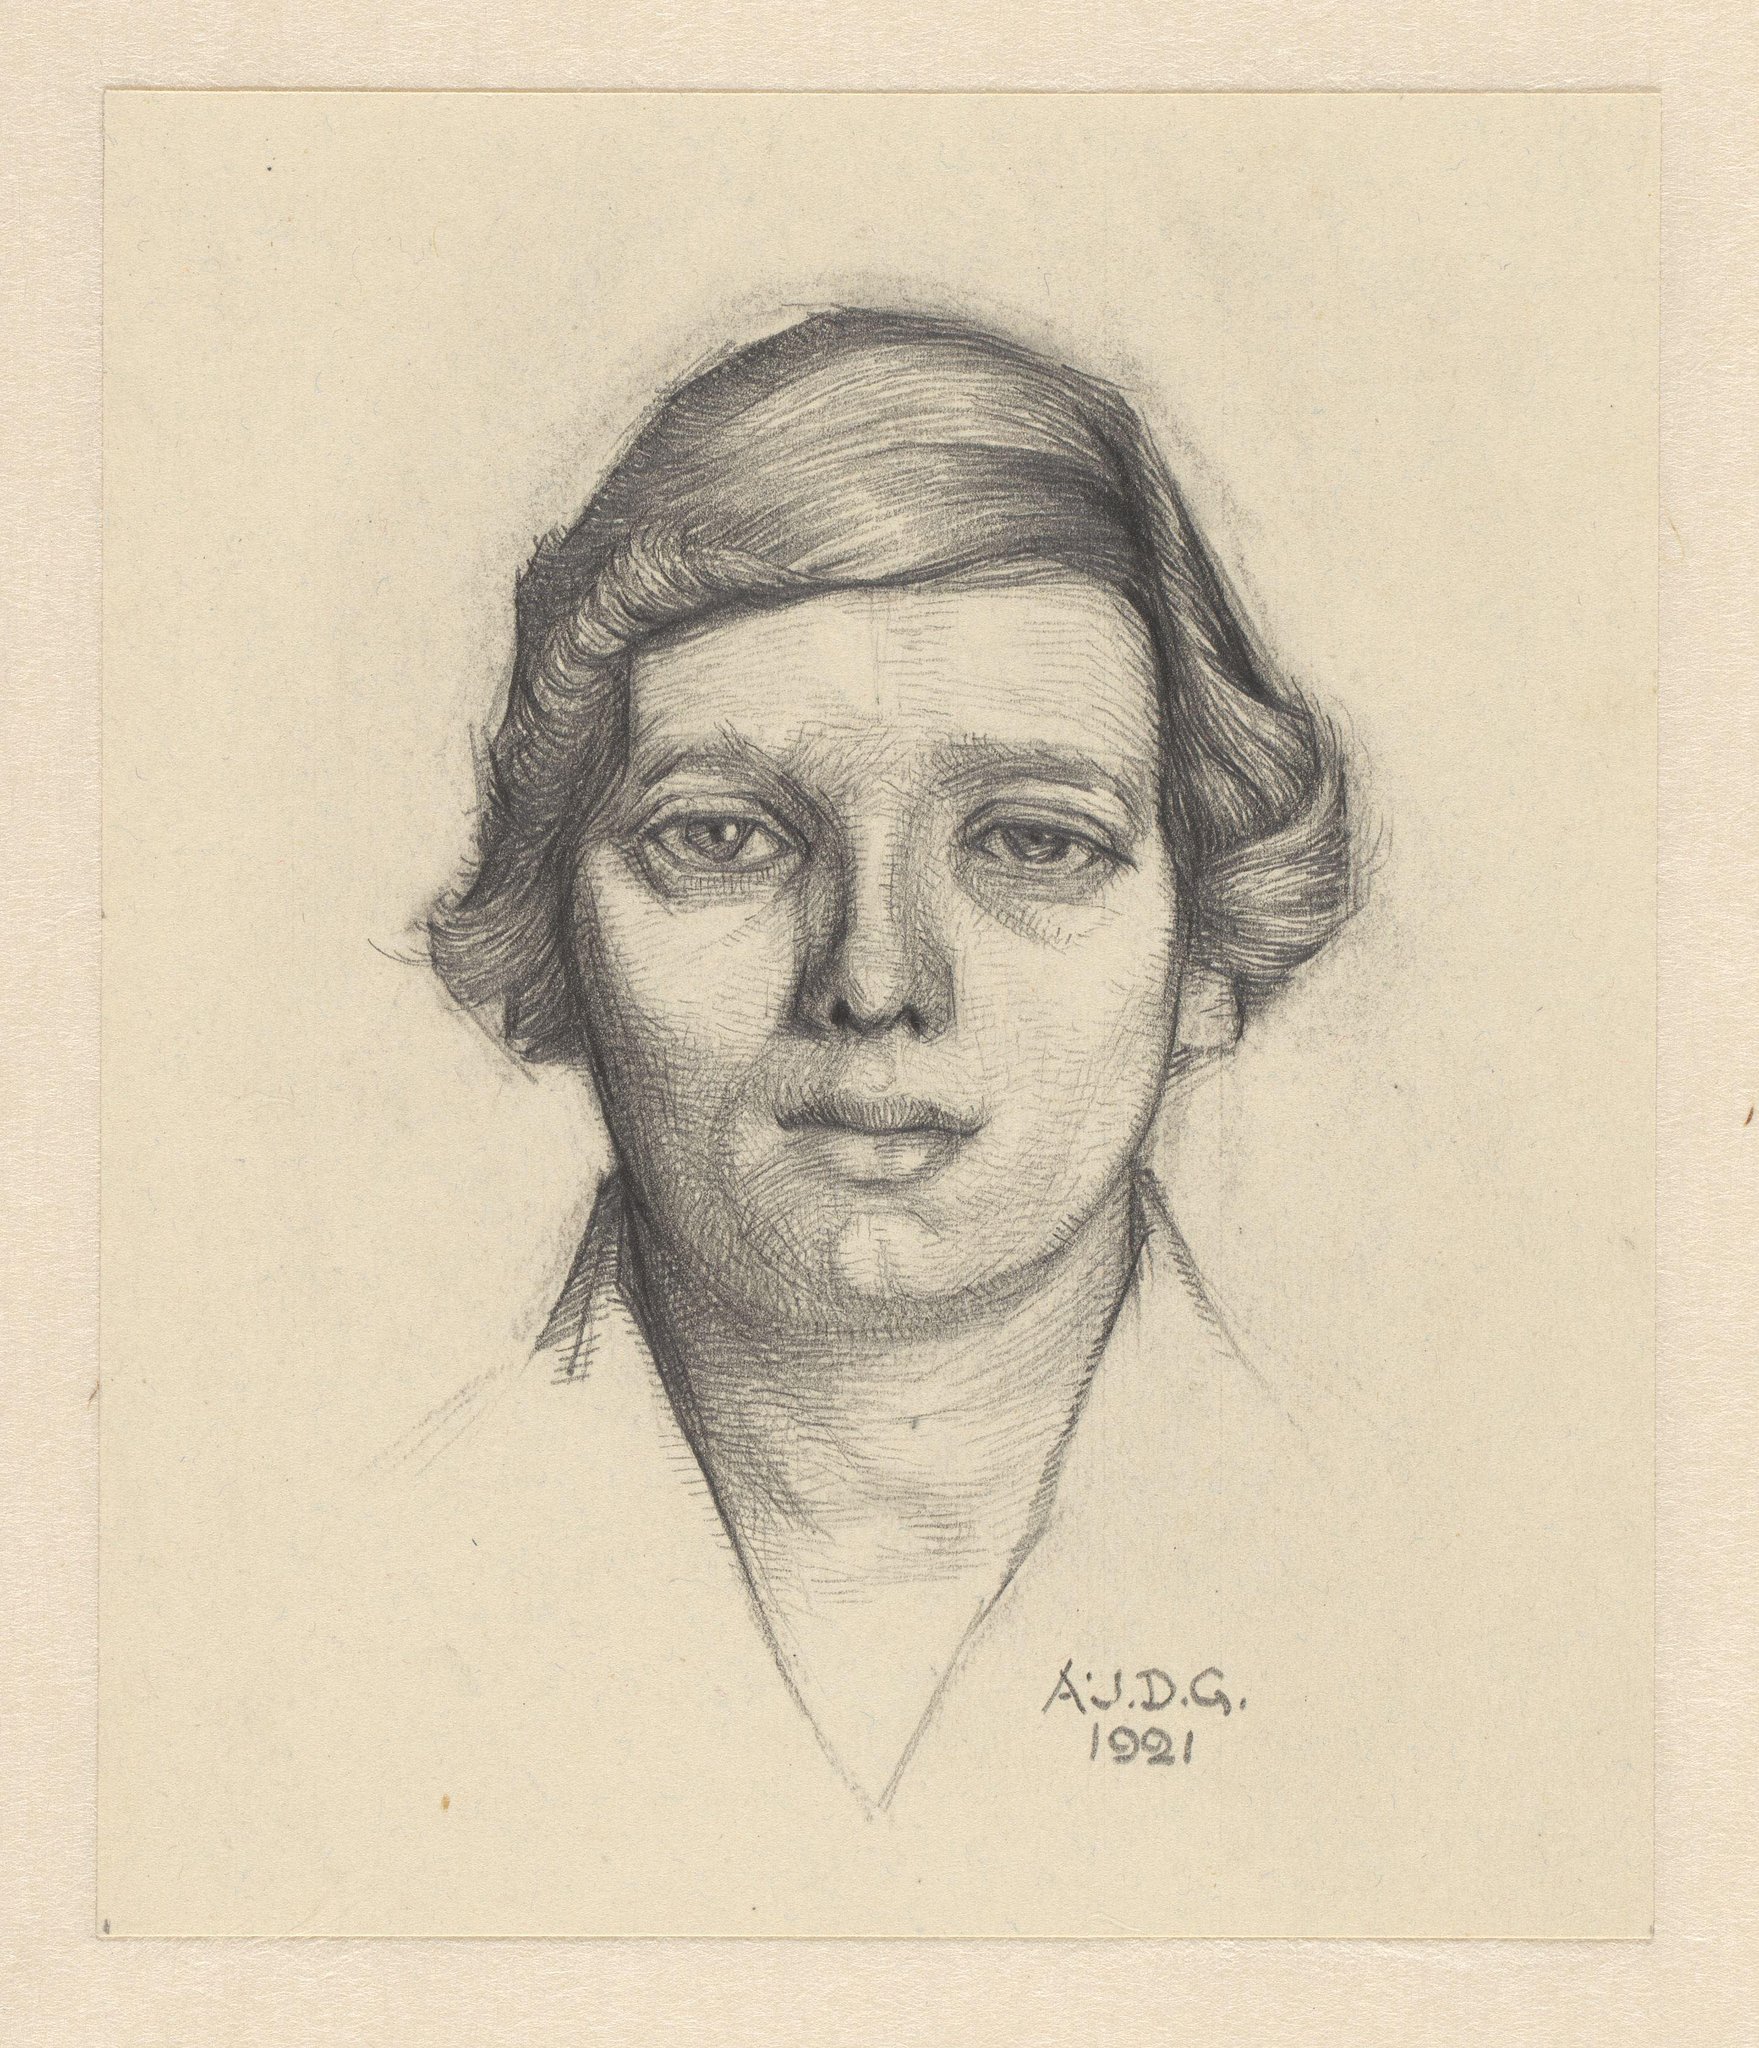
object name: drawing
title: Portret van een onbekende vrouw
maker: julie de graag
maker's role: draughtsman, print maker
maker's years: 1877-1924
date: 1921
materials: paper, pencil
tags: historical persons not known by name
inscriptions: annotation: ‘1/4 g[...]’, number: ‘20’